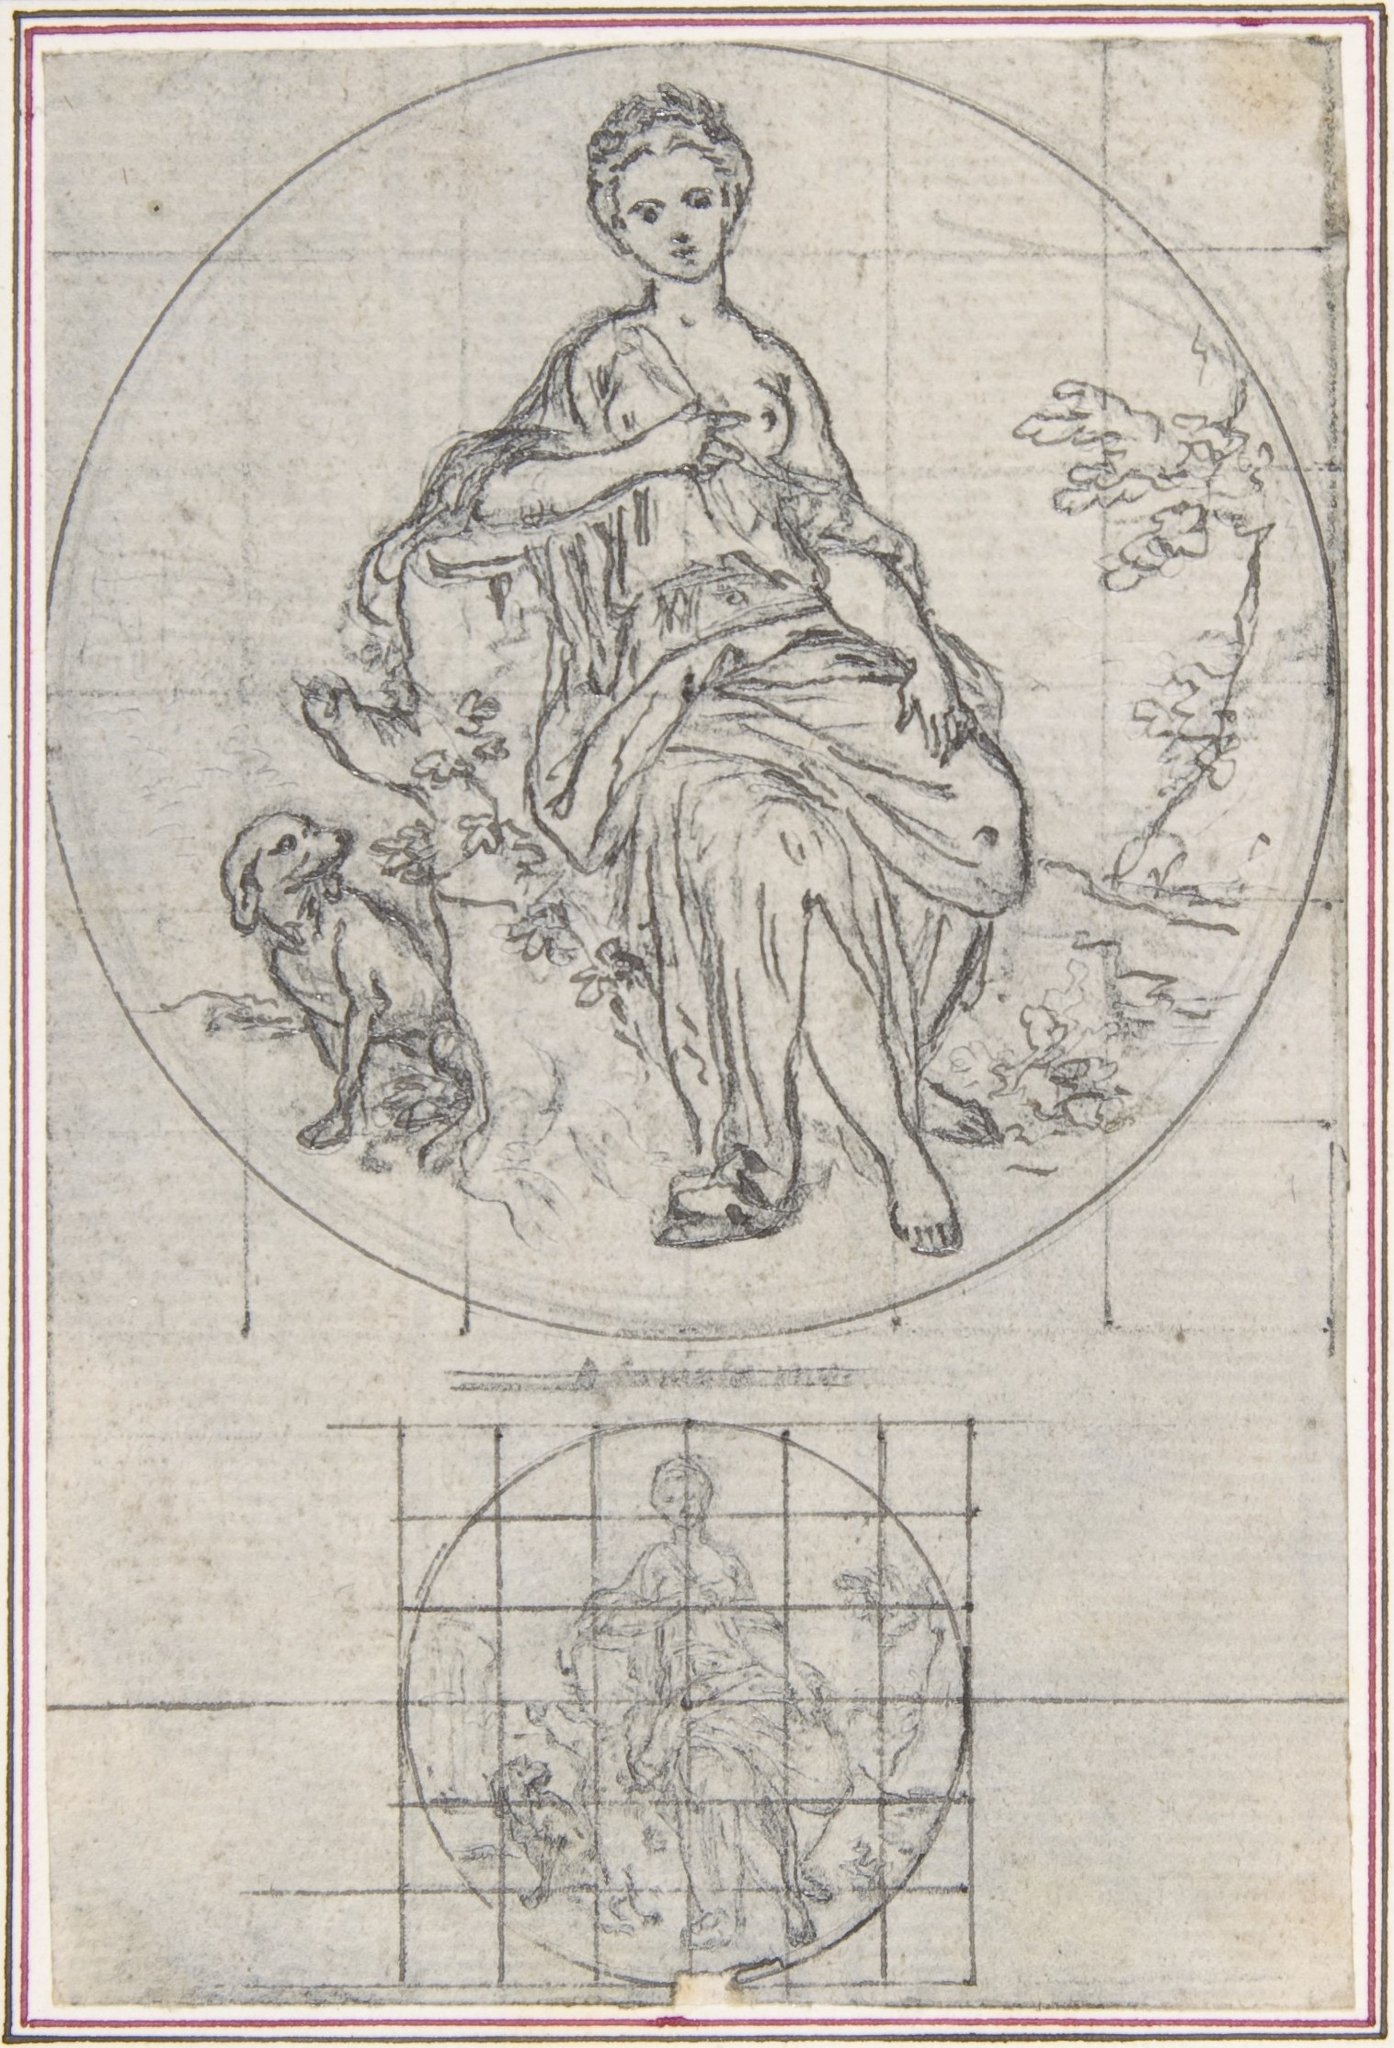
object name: drawing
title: Design for a Box-Lid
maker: hubert françois gravelot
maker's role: artist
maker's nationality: french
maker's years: 1699-1773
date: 1701-1800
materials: chalk, ink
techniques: pen, drawing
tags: women,dogs